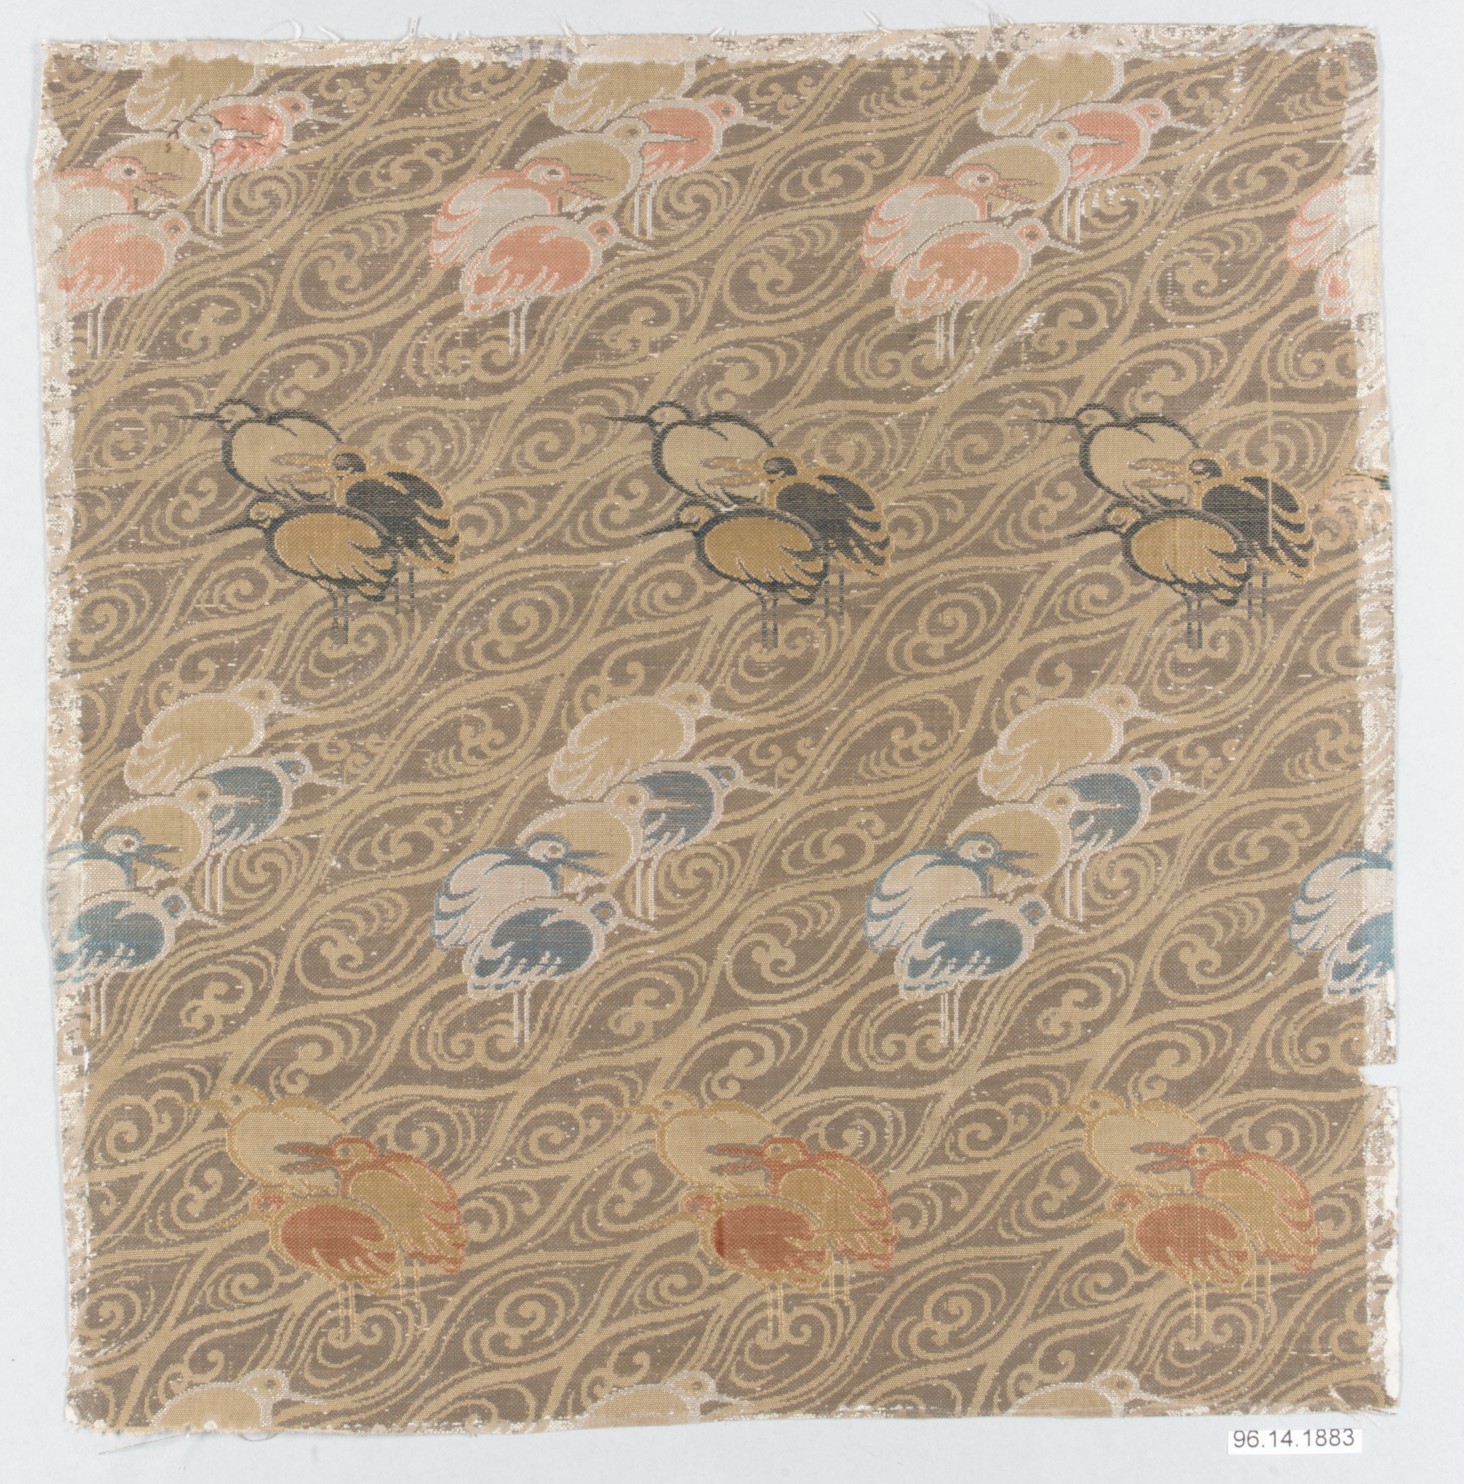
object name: piece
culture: japanese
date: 1801-1900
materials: silk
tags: birds